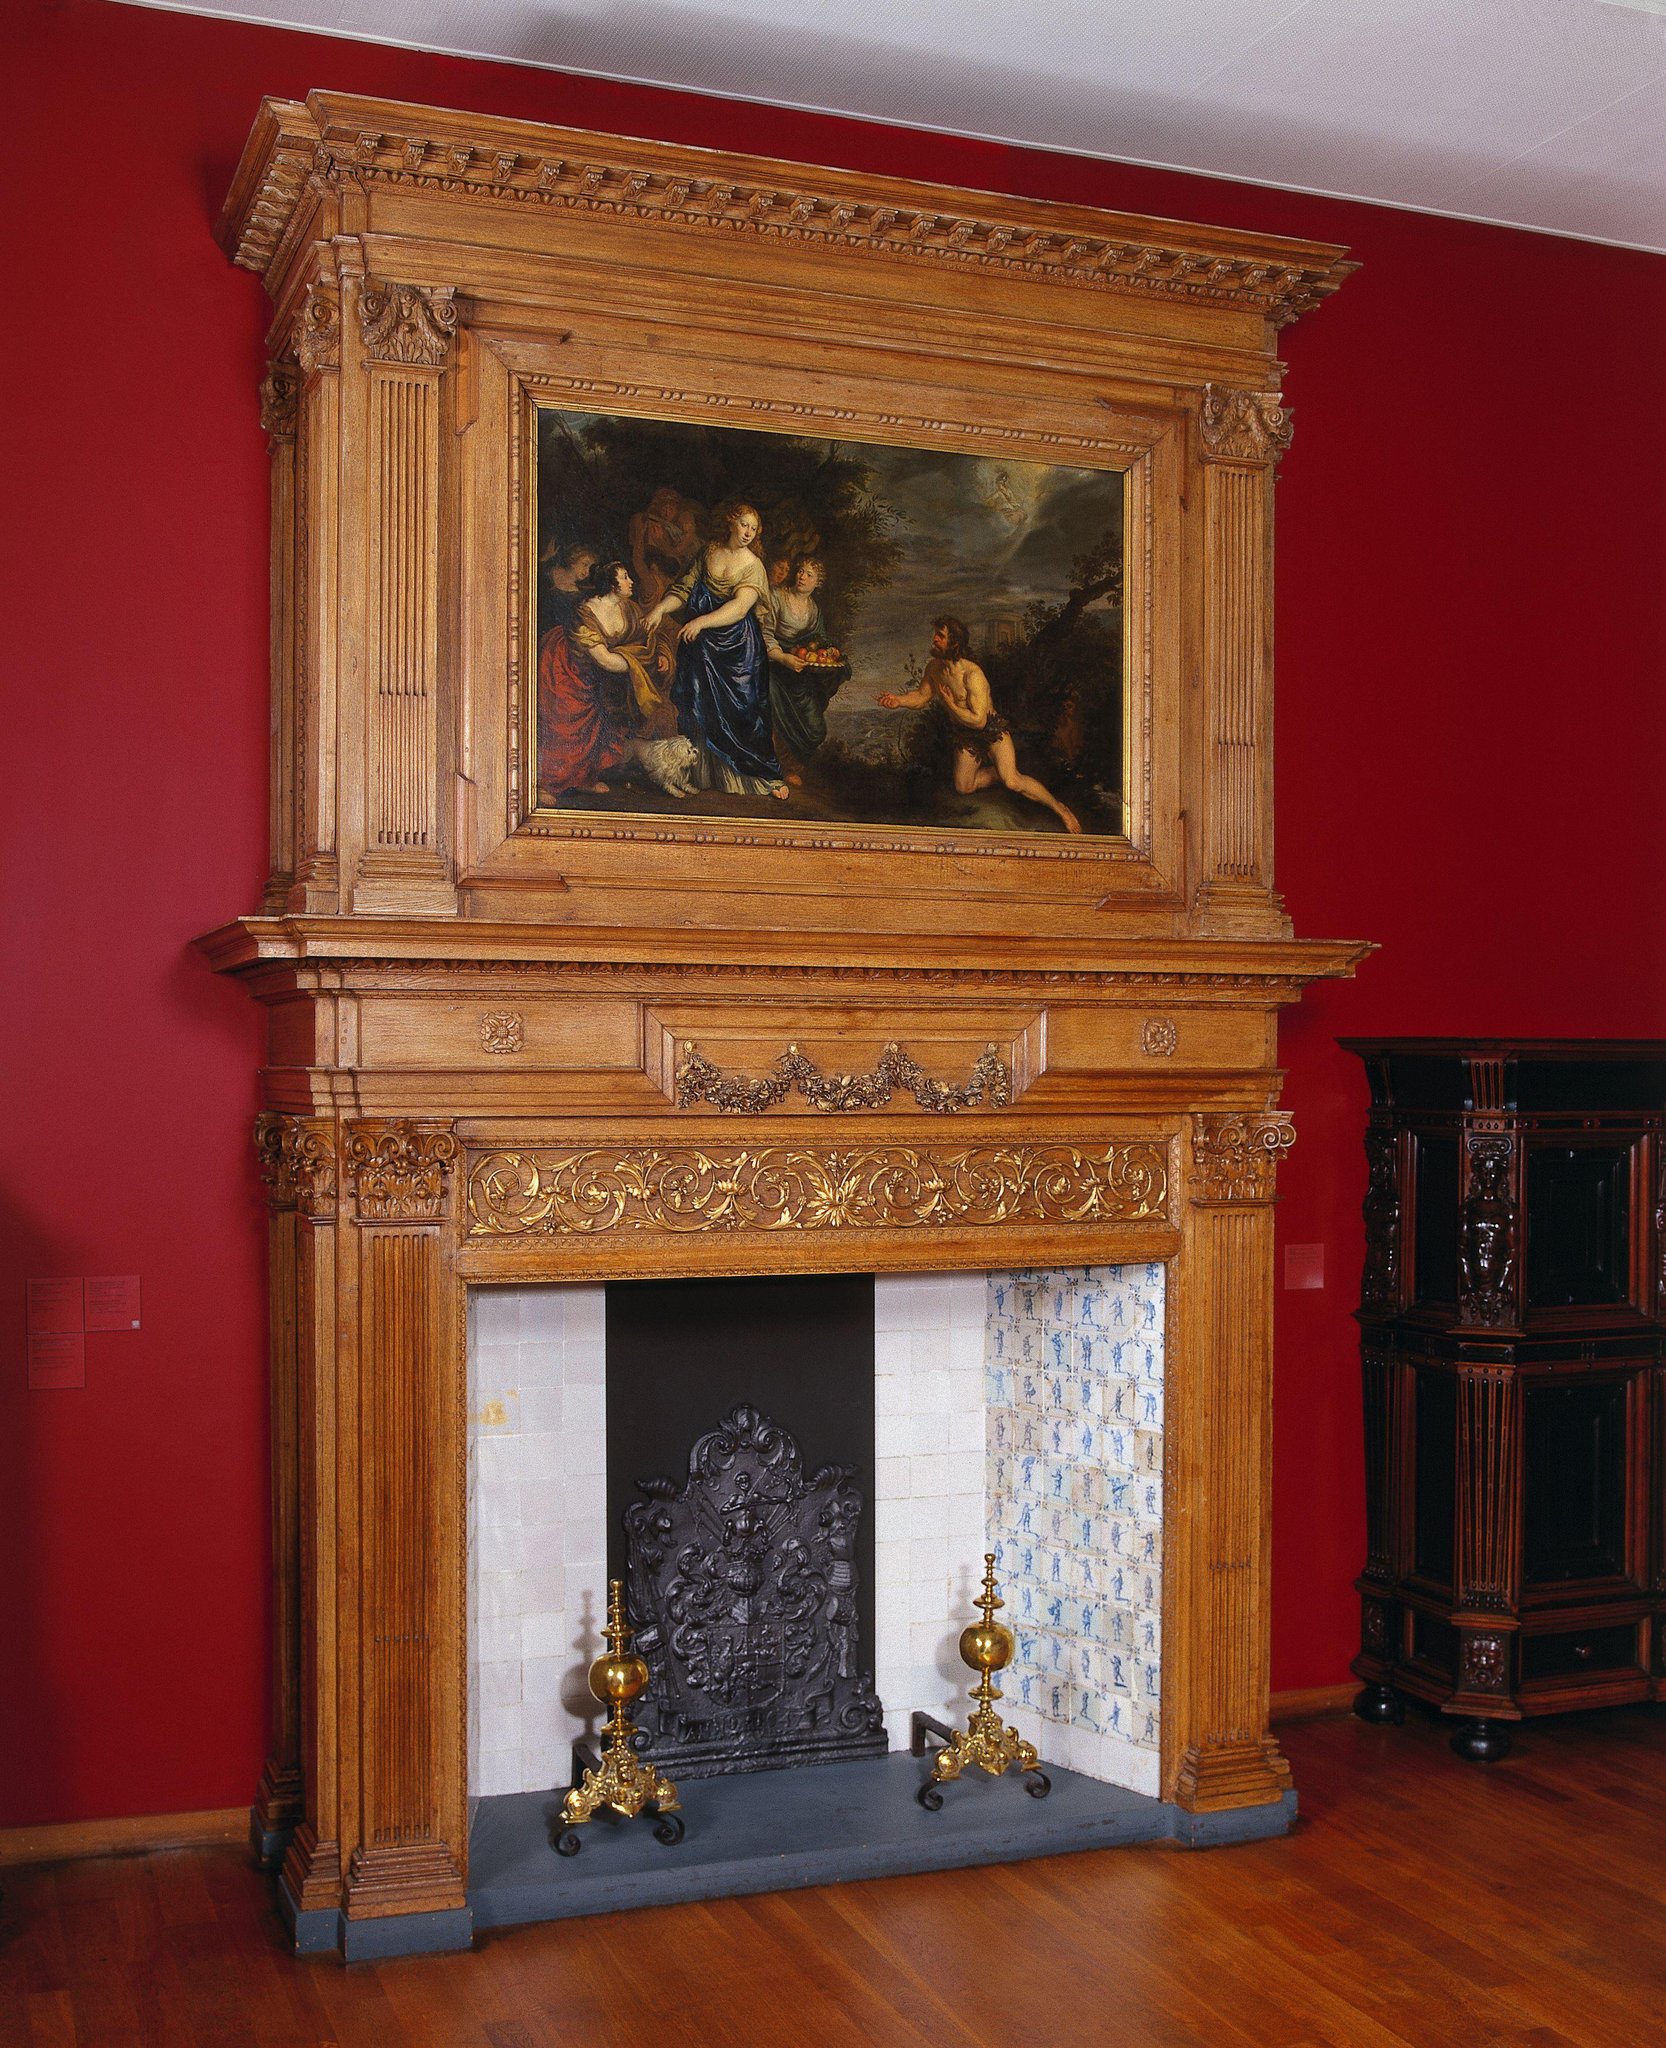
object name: interieuronderdeel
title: Linker zijpaneel van de schoorsteen van het Huydecoperhuis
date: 1639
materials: wood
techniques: gilding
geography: northern netherlands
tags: architectural detail, meeting of nausicaa and ulysses: ulysses, almost naked, comes out of the bushes; nausicaa and her companions are startled at the sight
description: Linker zijpaneel van de schoorsteen van het Huydecoperhuis.